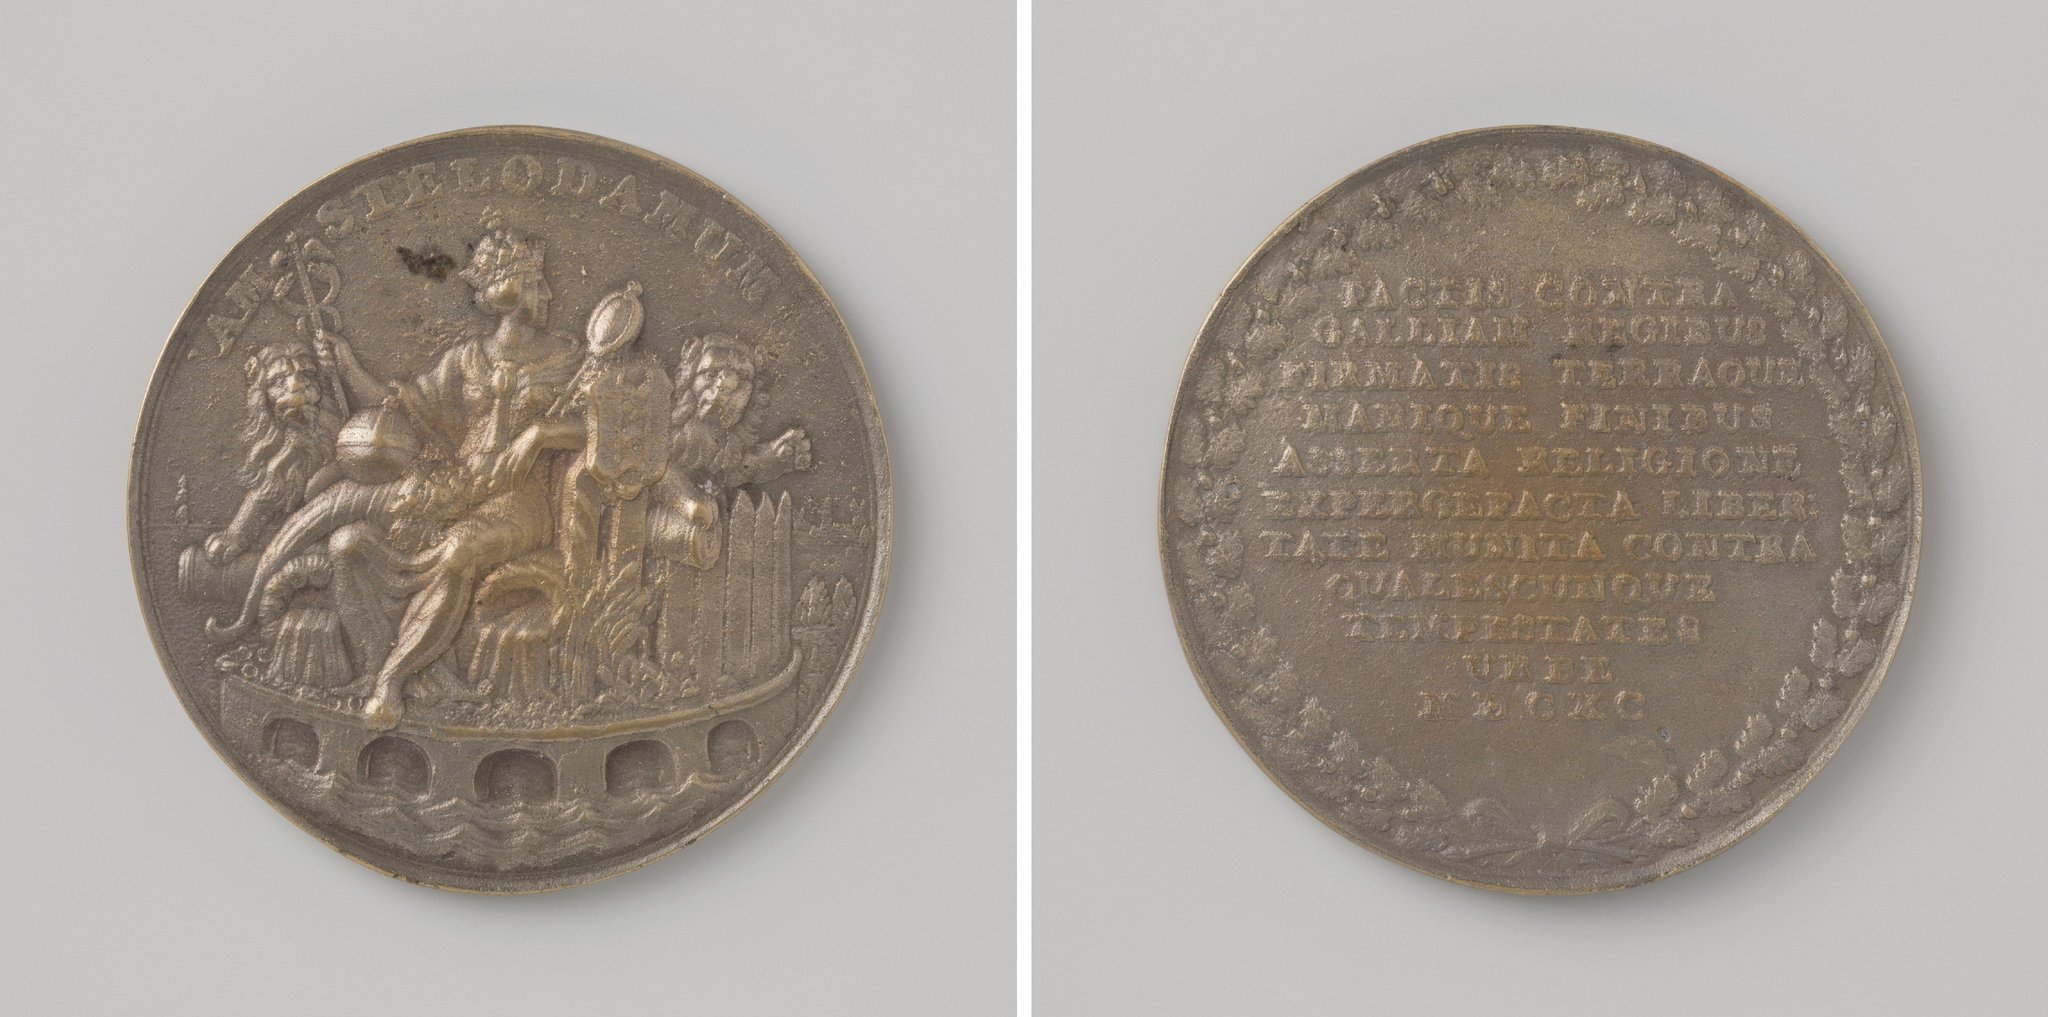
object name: history medal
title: Amsterdam naar het plan van Jacob Hudde tegen watersnood beschermd 1690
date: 1690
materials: brass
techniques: casting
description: Gegoten messing penning, verzilverd, op de voorzijde de Amsterdamse Stedemaagd op een beschermde ronde vesting, bovenaan AMSTELODAMUM, op de keerzijde een elfregelige tekst